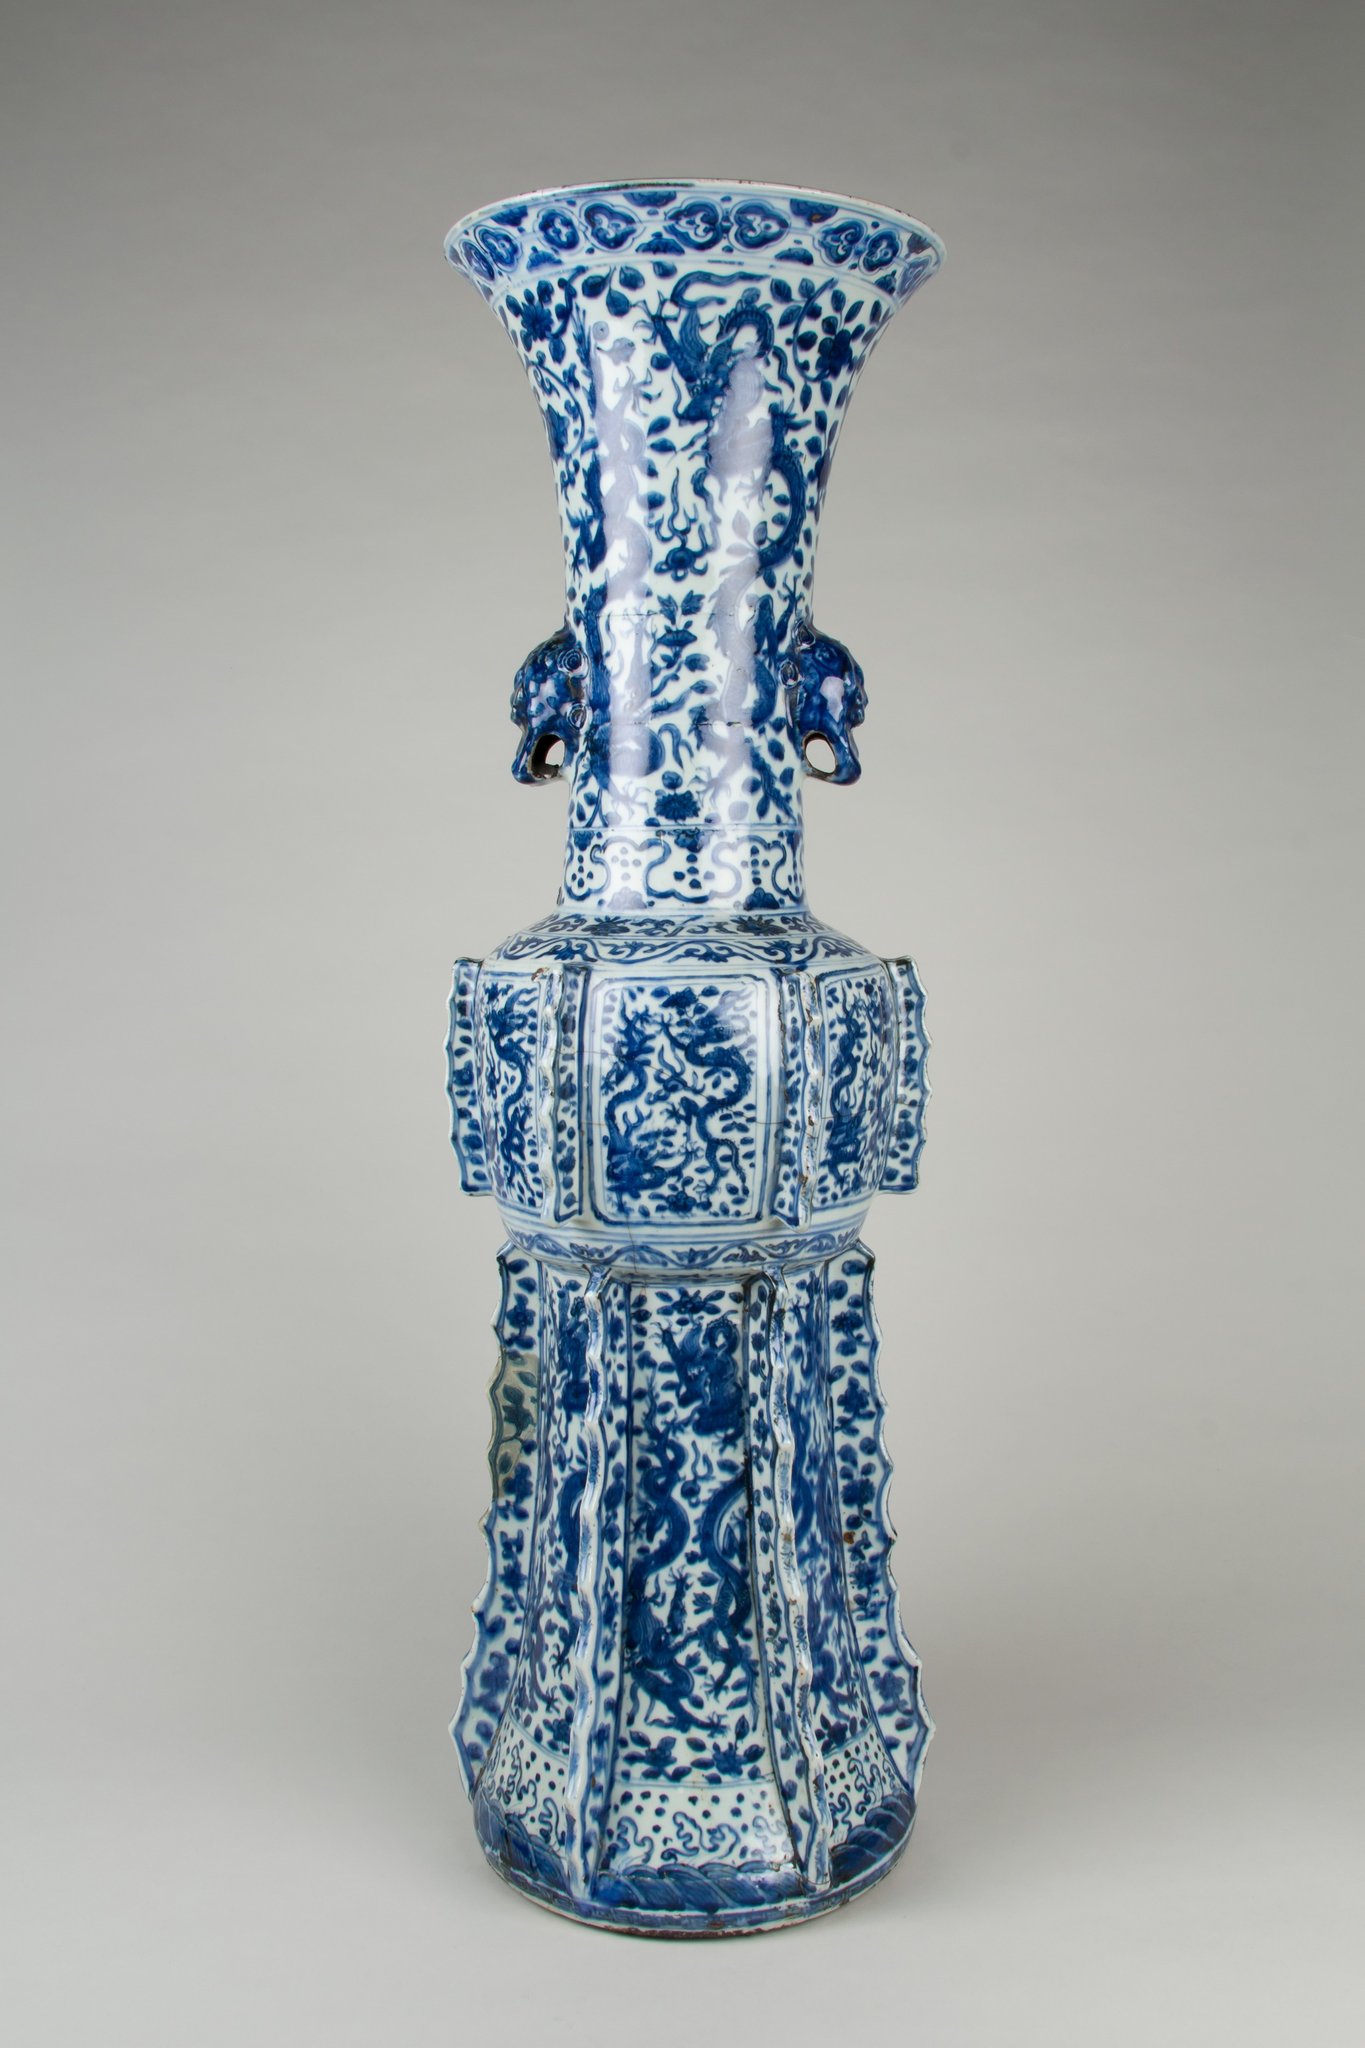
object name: vase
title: Vase with dragons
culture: chinese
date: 1567-1600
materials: cobalt, porcelain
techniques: painting, underglaze